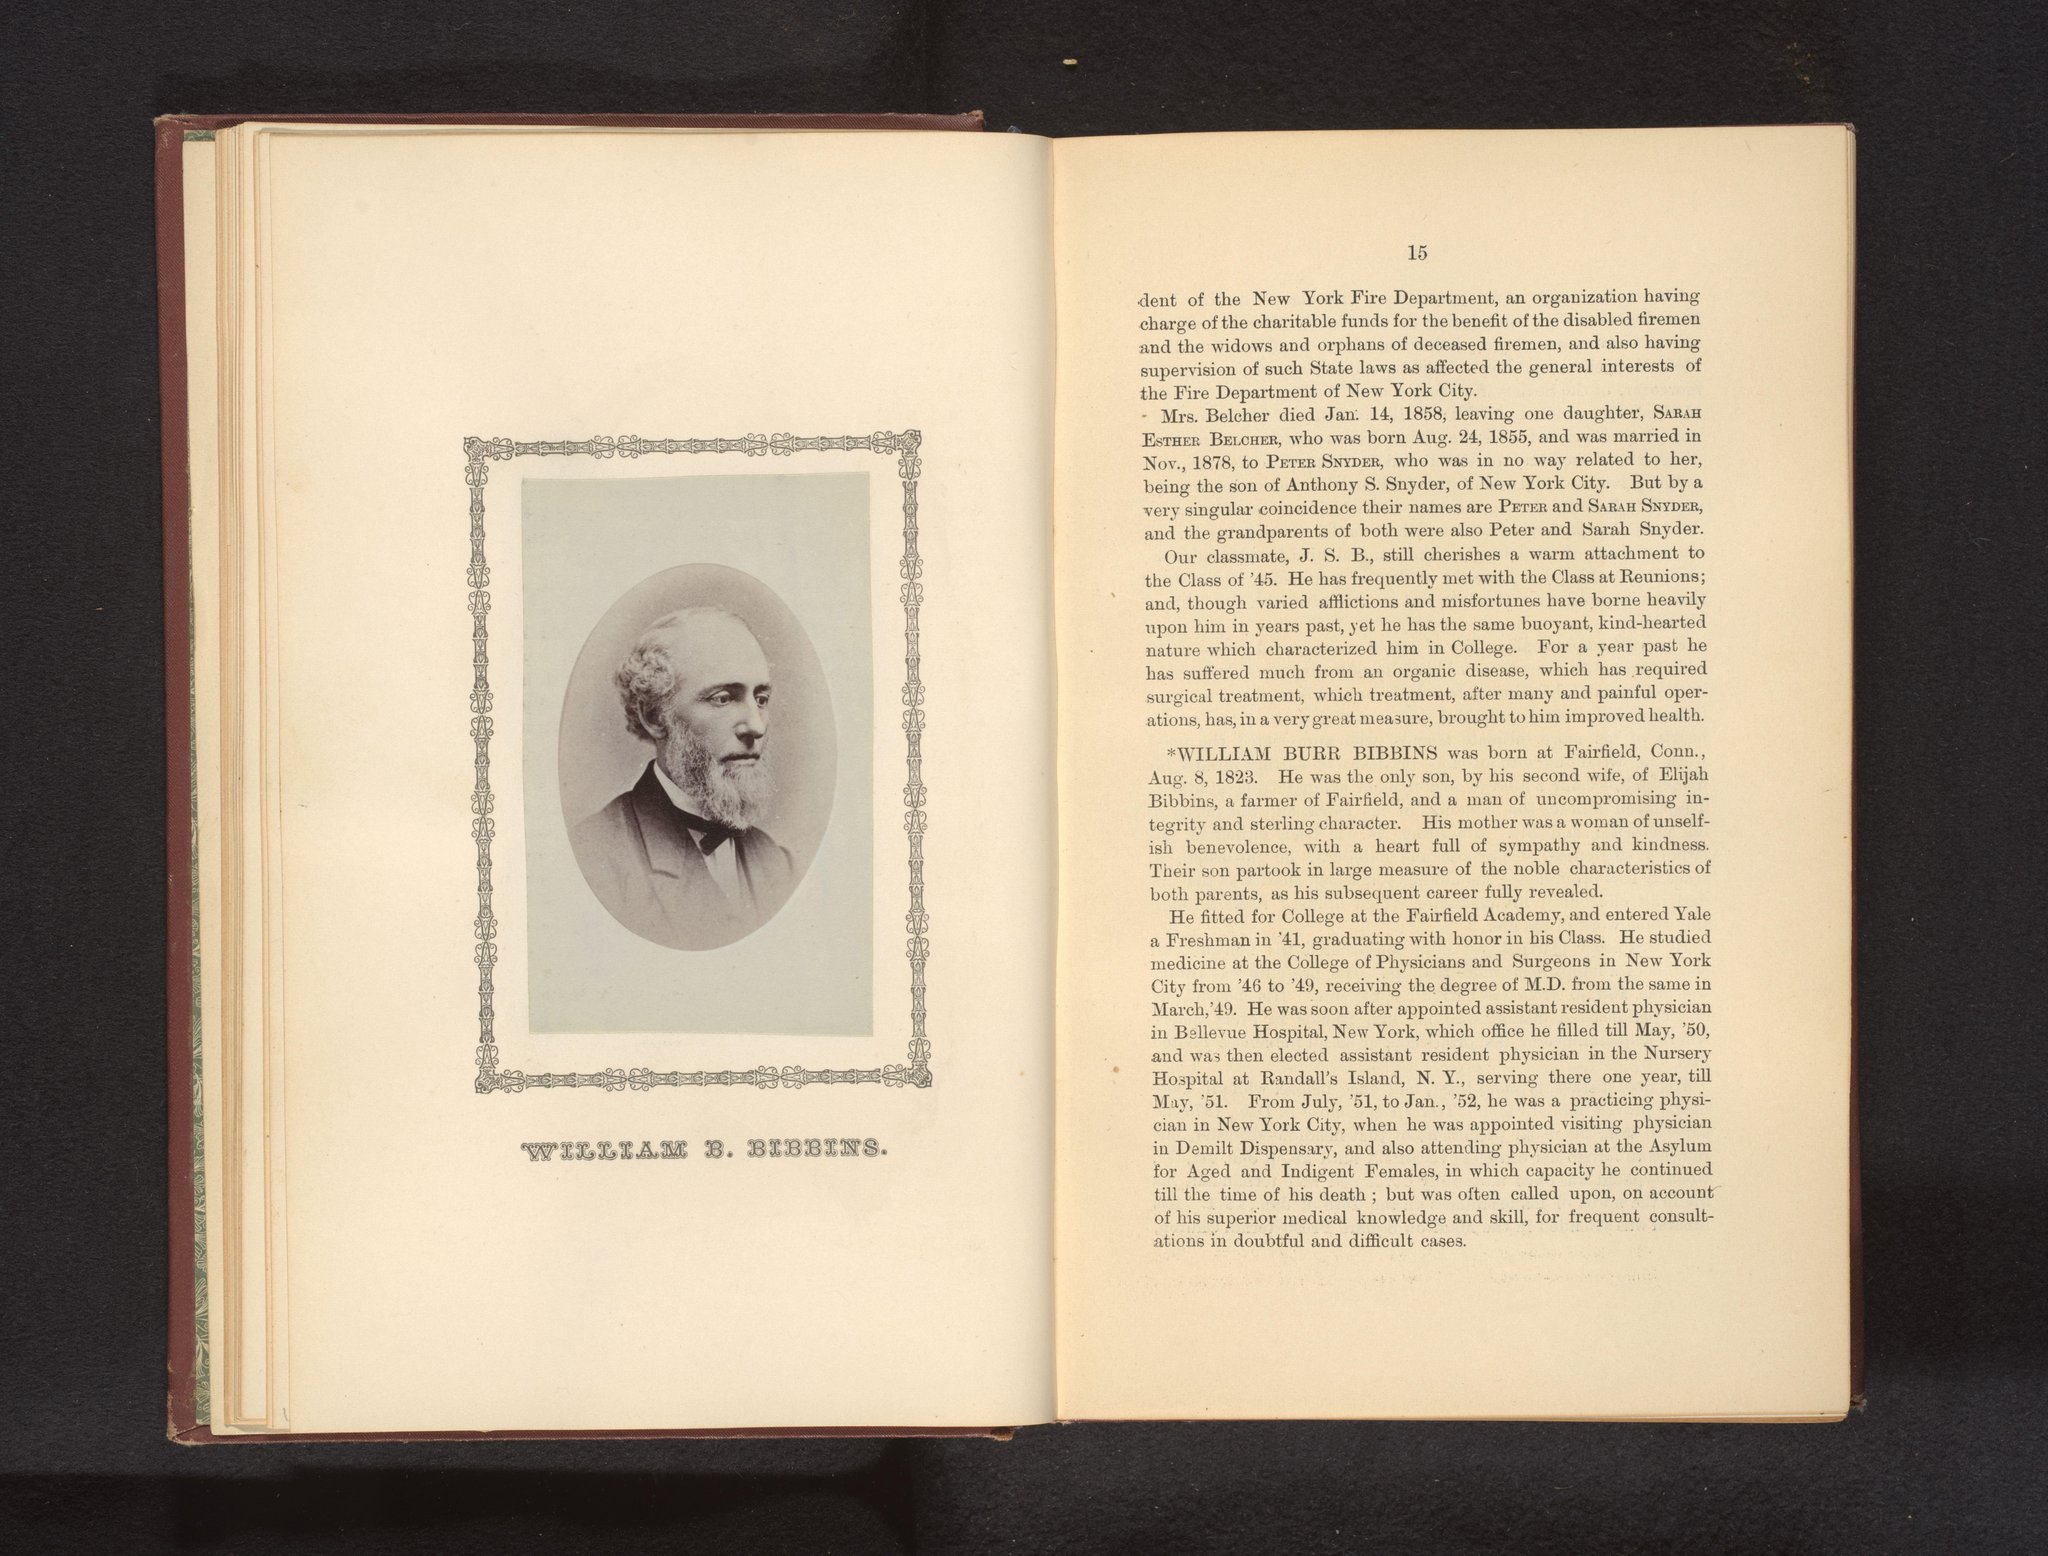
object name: photograph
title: William B. Bibbins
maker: Anonymous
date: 1876-1881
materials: photographic support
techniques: albumen print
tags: adult man